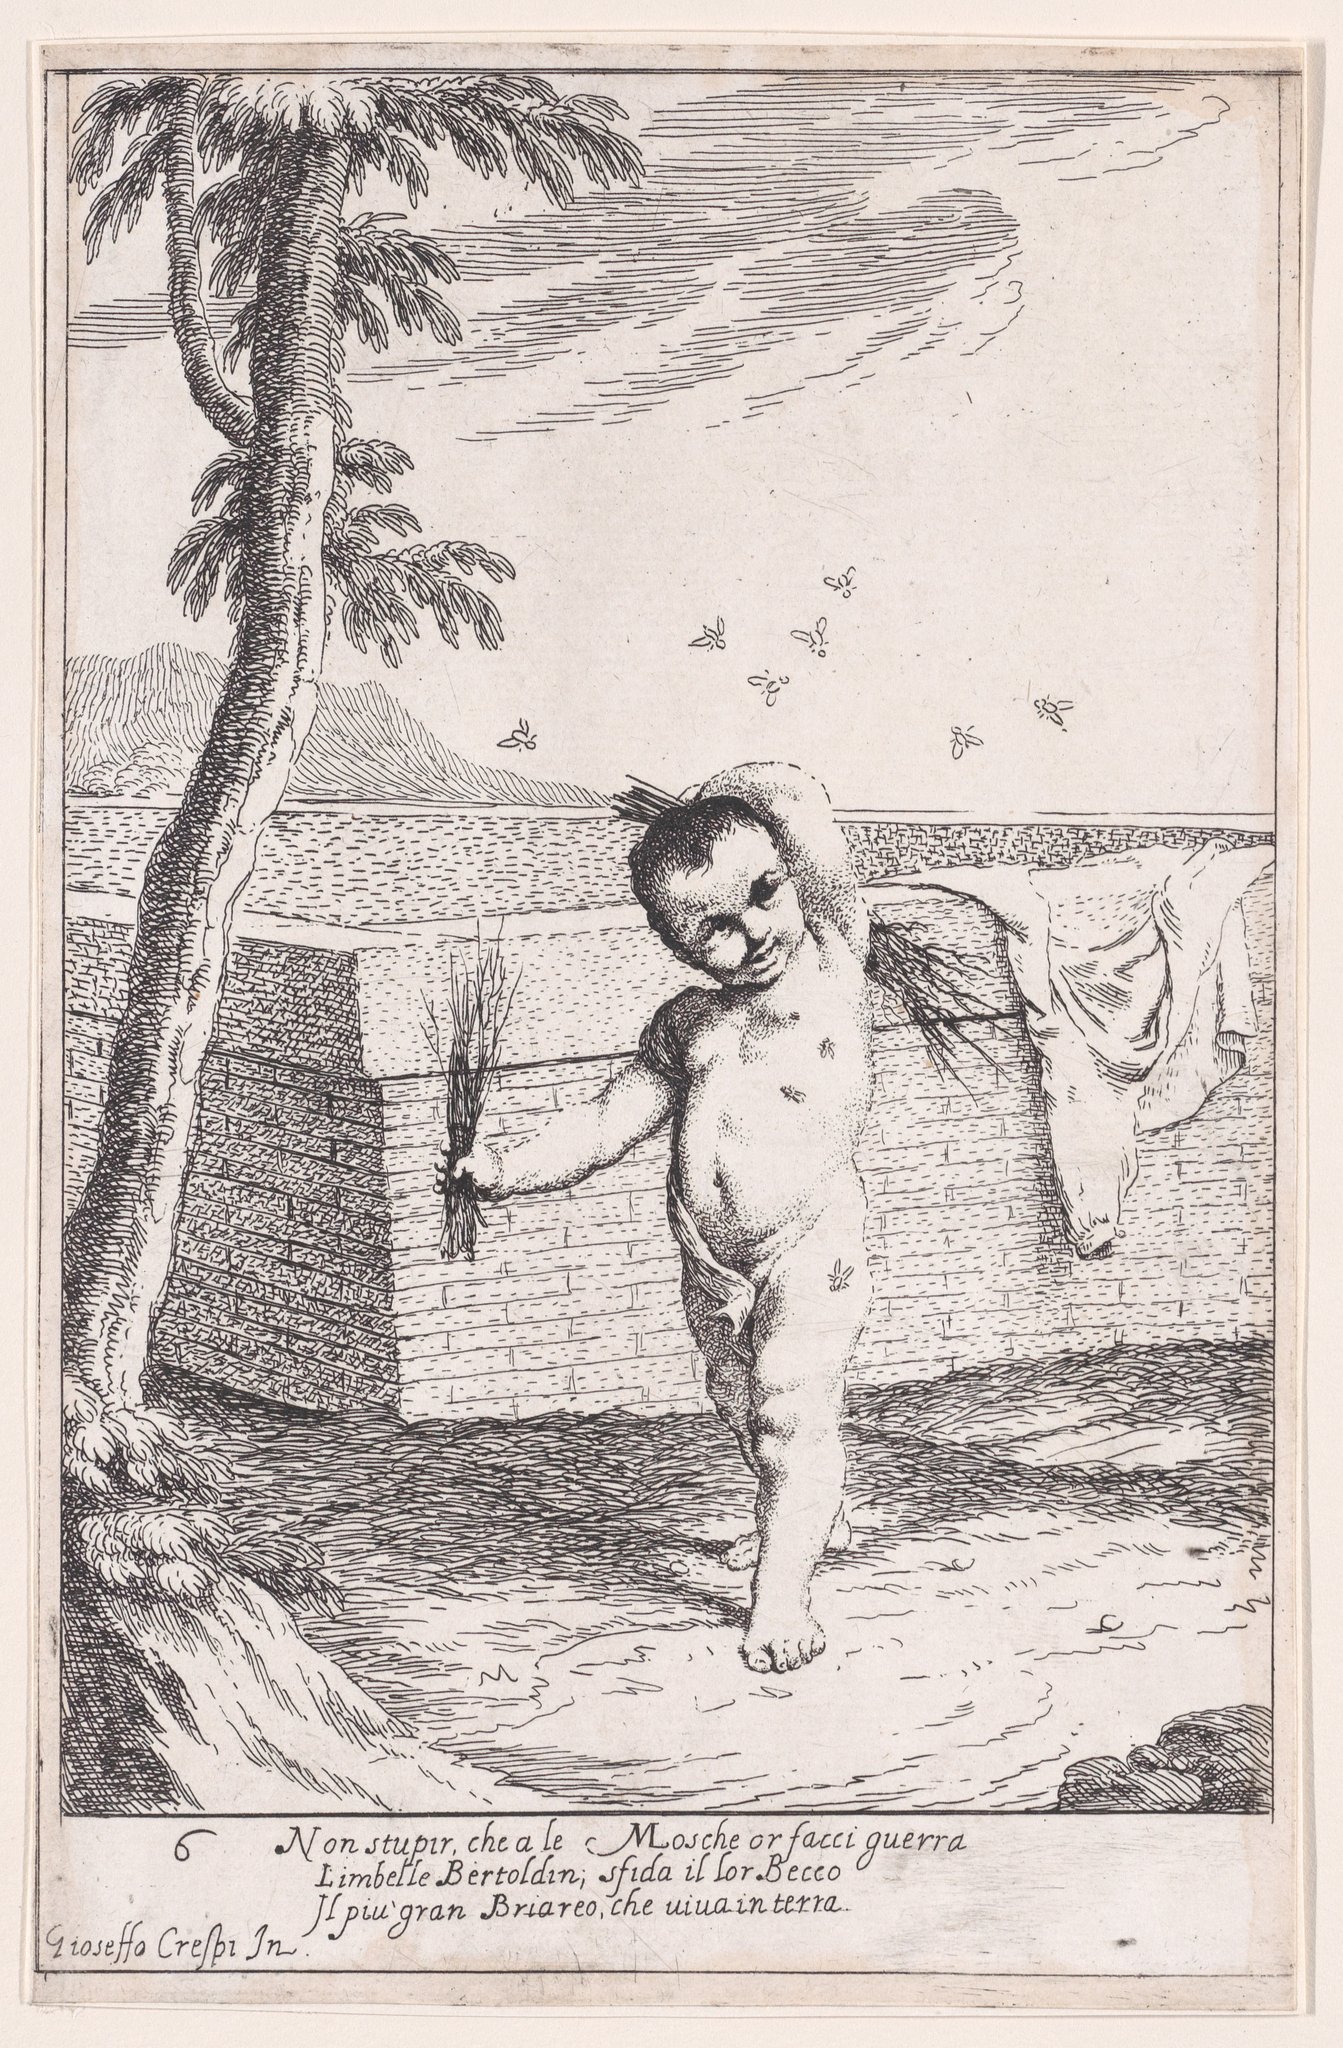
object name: print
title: Plate 12: Bertoldino whipping himself to kill flies, from "Bertoldo, Bertoldino, and Cacasenno"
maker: giuseppe maria crespi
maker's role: artist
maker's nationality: italian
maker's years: 1665-1747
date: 1705-1715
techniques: etching